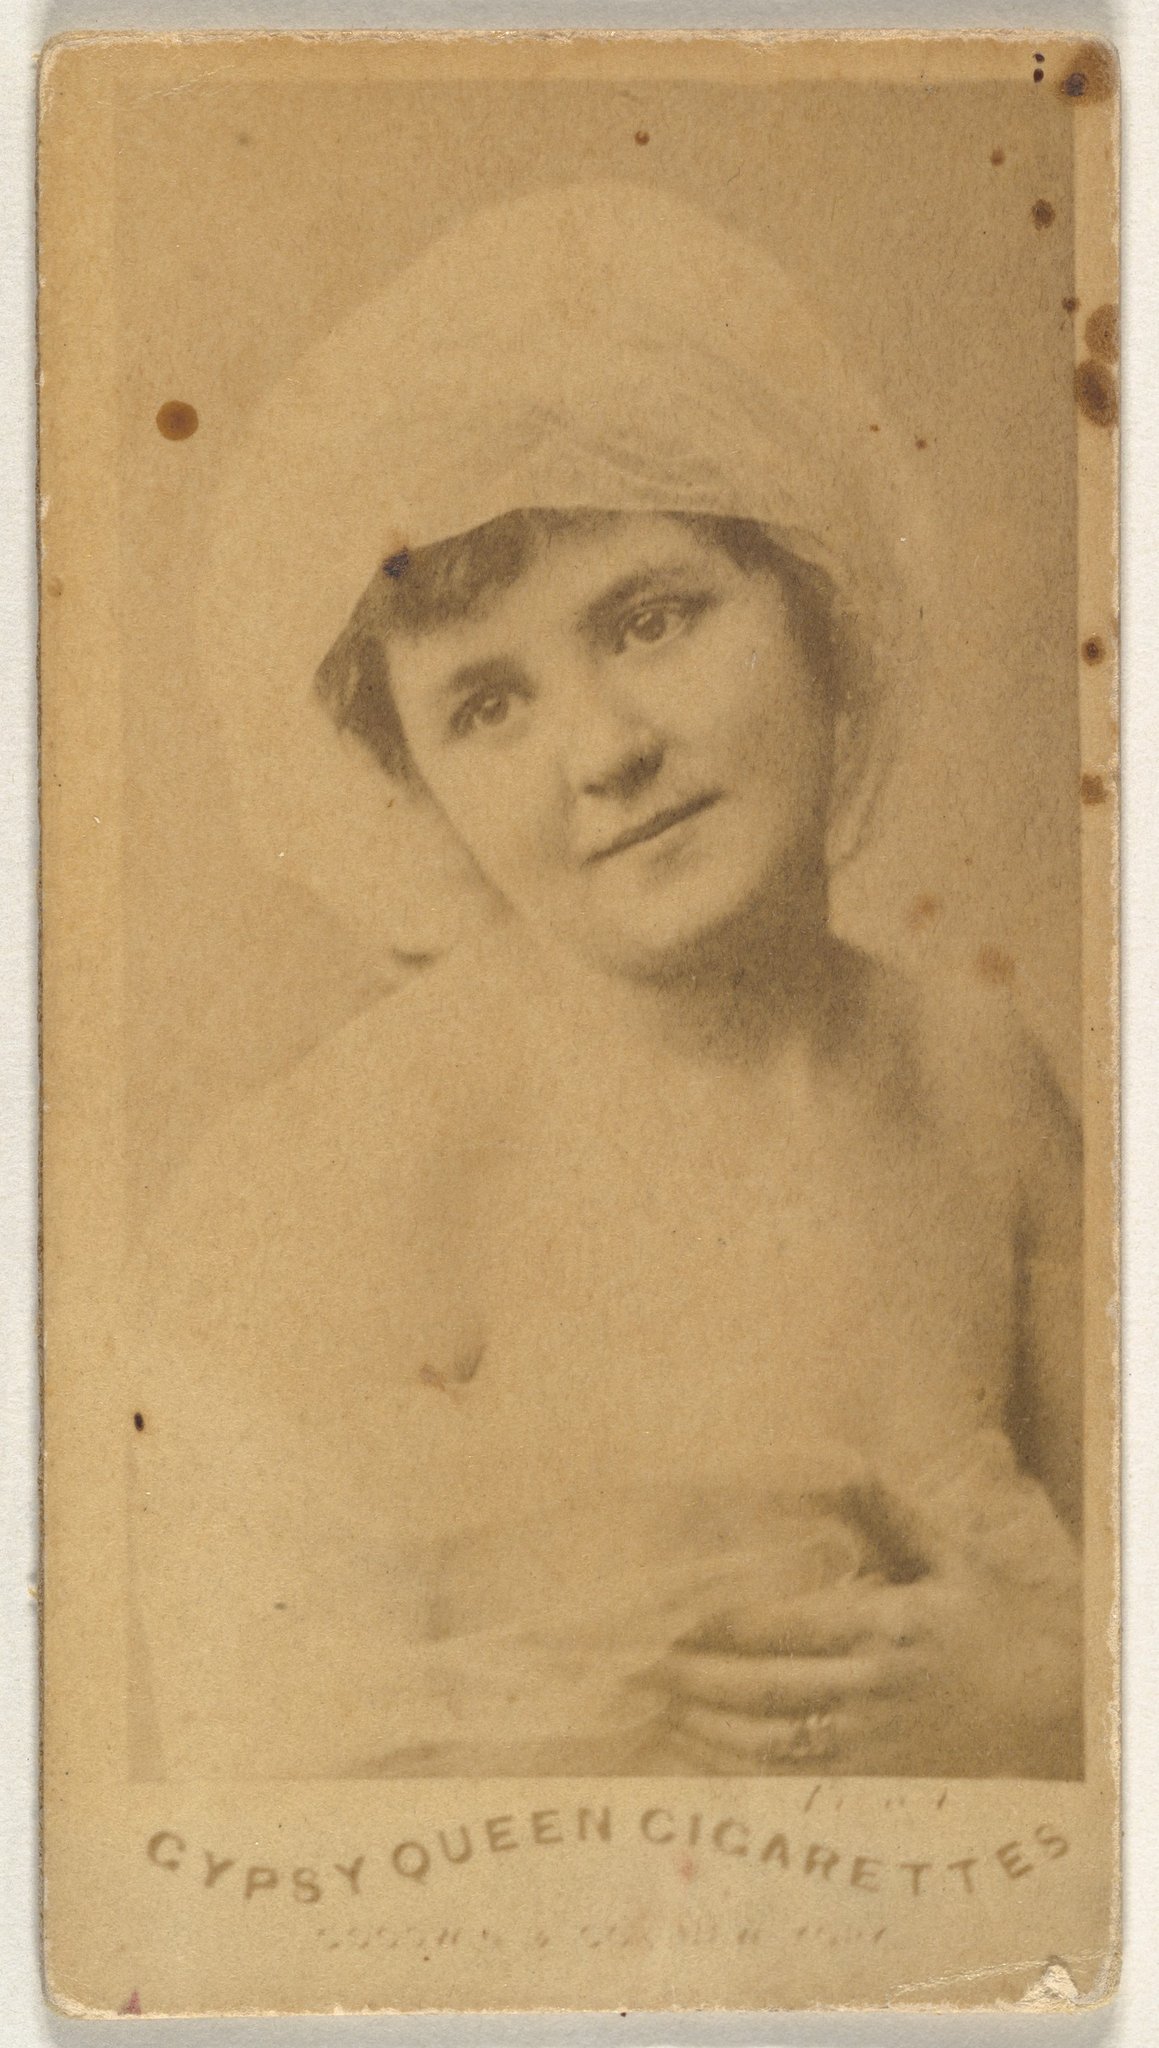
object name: photograph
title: From the Actors and Actresses series (N171) for Gypsy Queen Cigarettes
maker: goodwin & company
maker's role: publisher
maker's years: 1850-1950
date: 1886-1890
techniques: albumen silver print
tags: portraits,women,actresses